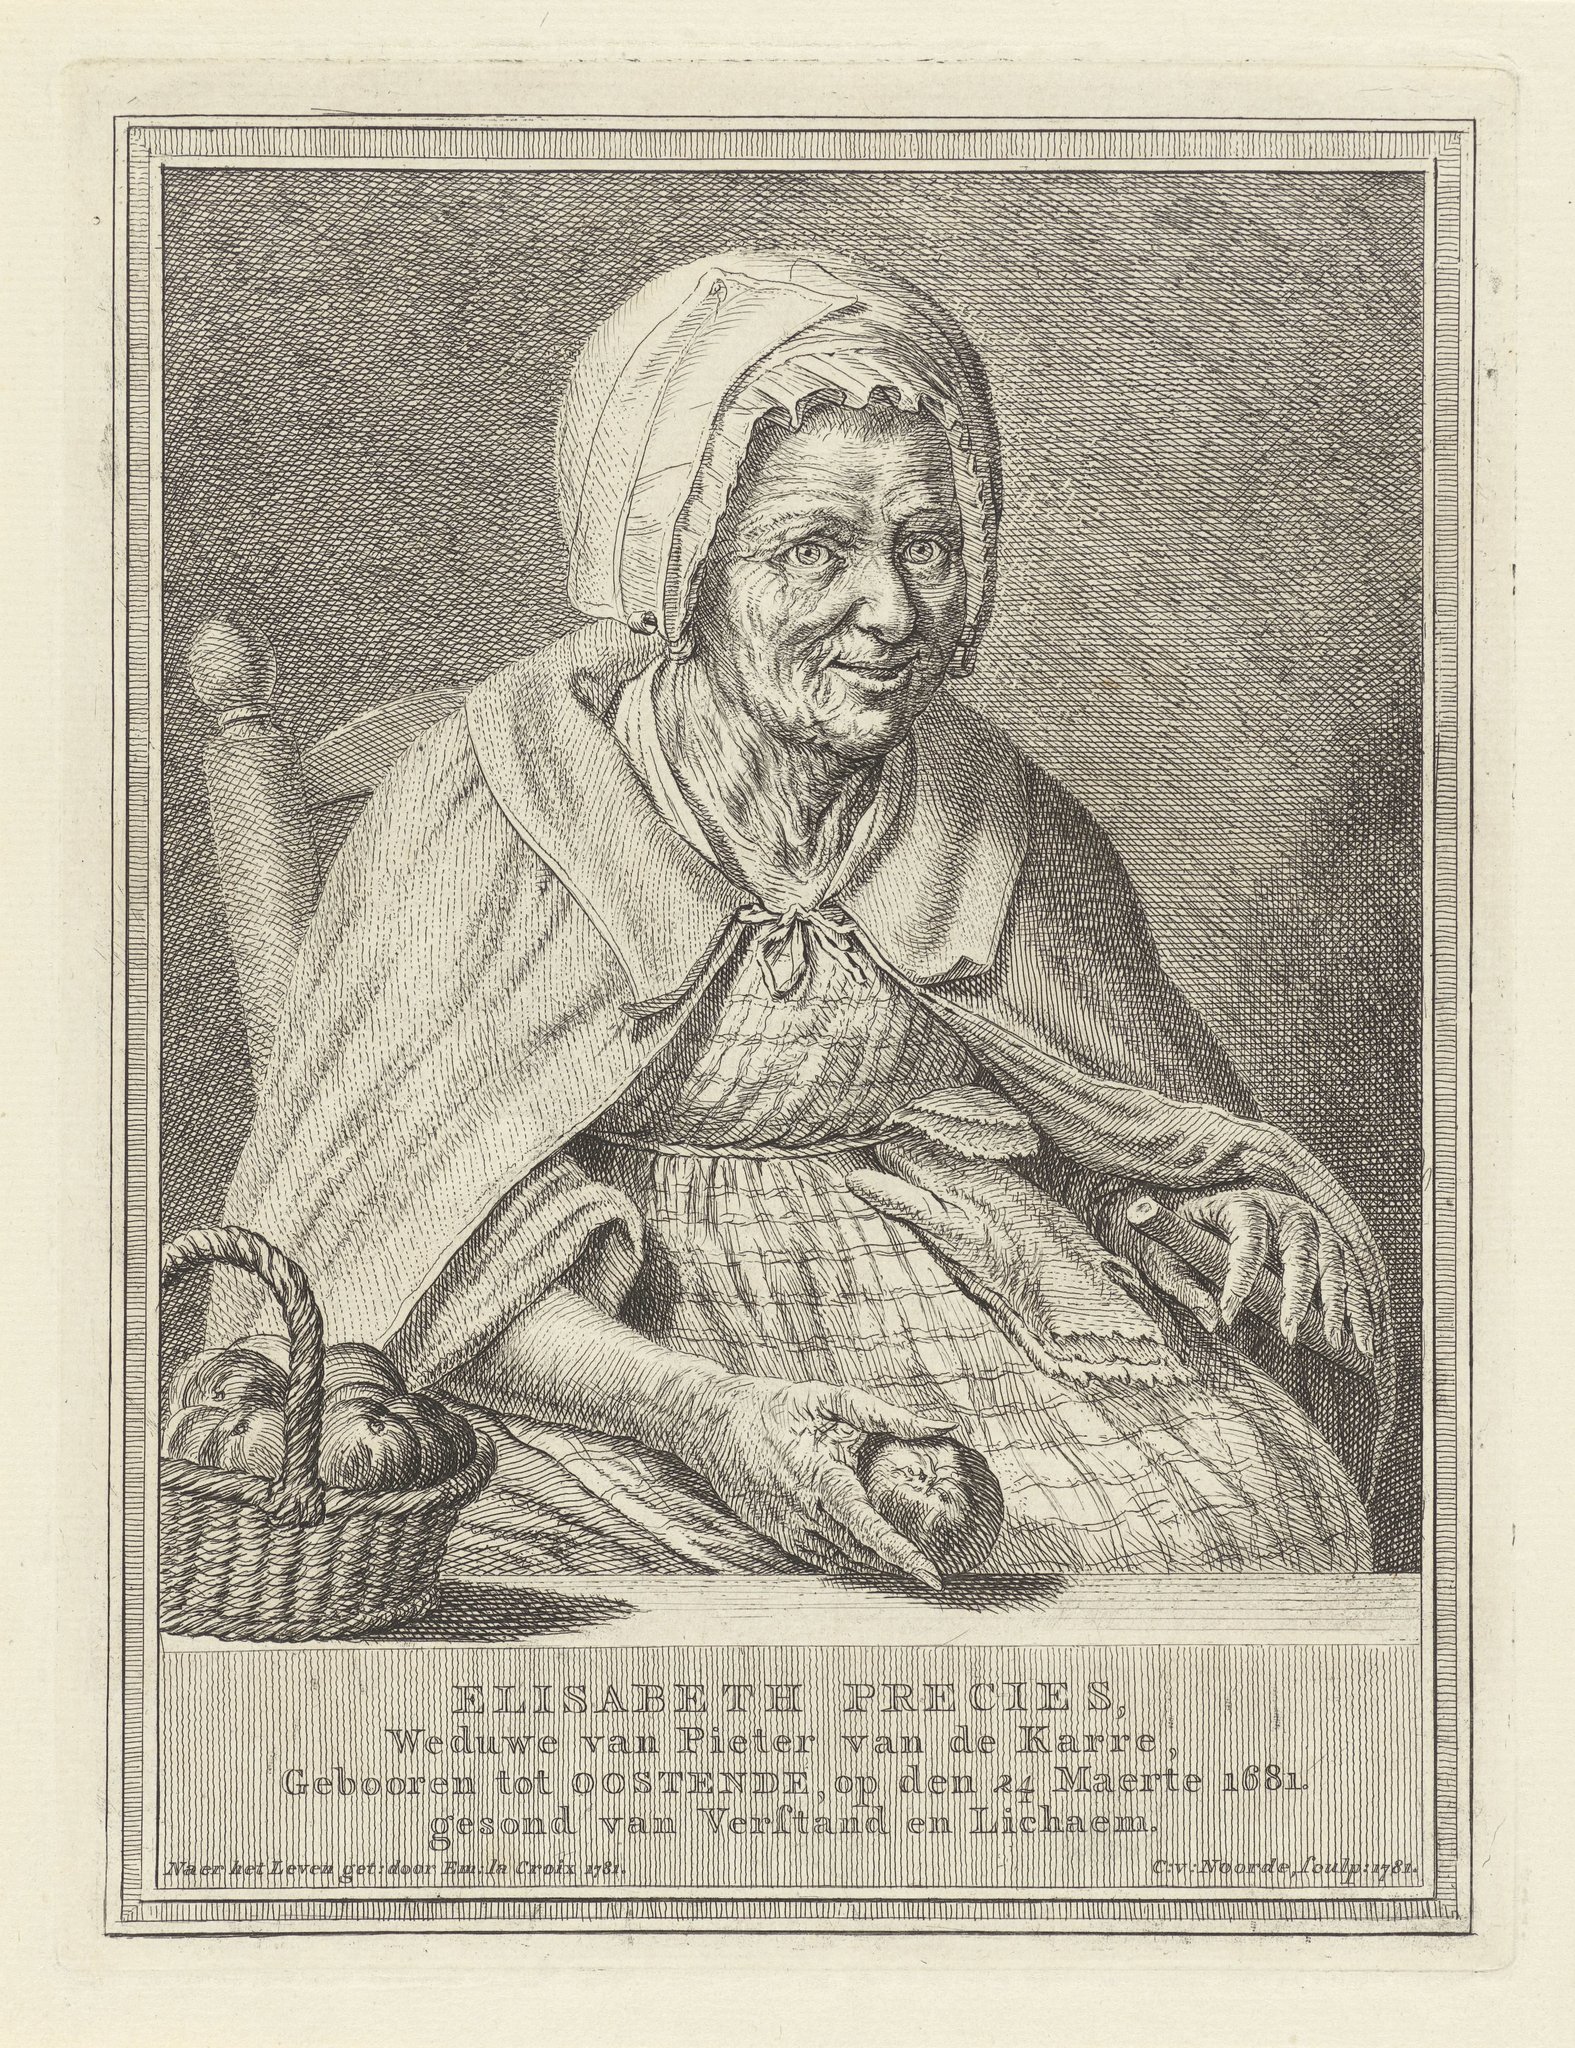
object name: print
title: Portret van Elisabeth Precies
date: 1781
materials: paper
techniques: engraving, etching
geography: haarlem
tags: elisabeth precies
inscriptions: collector's mark: Lugt 2228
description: Portret van Elisabeth Precies, op 100-jarige leeftijd, met een appel in haar hand.